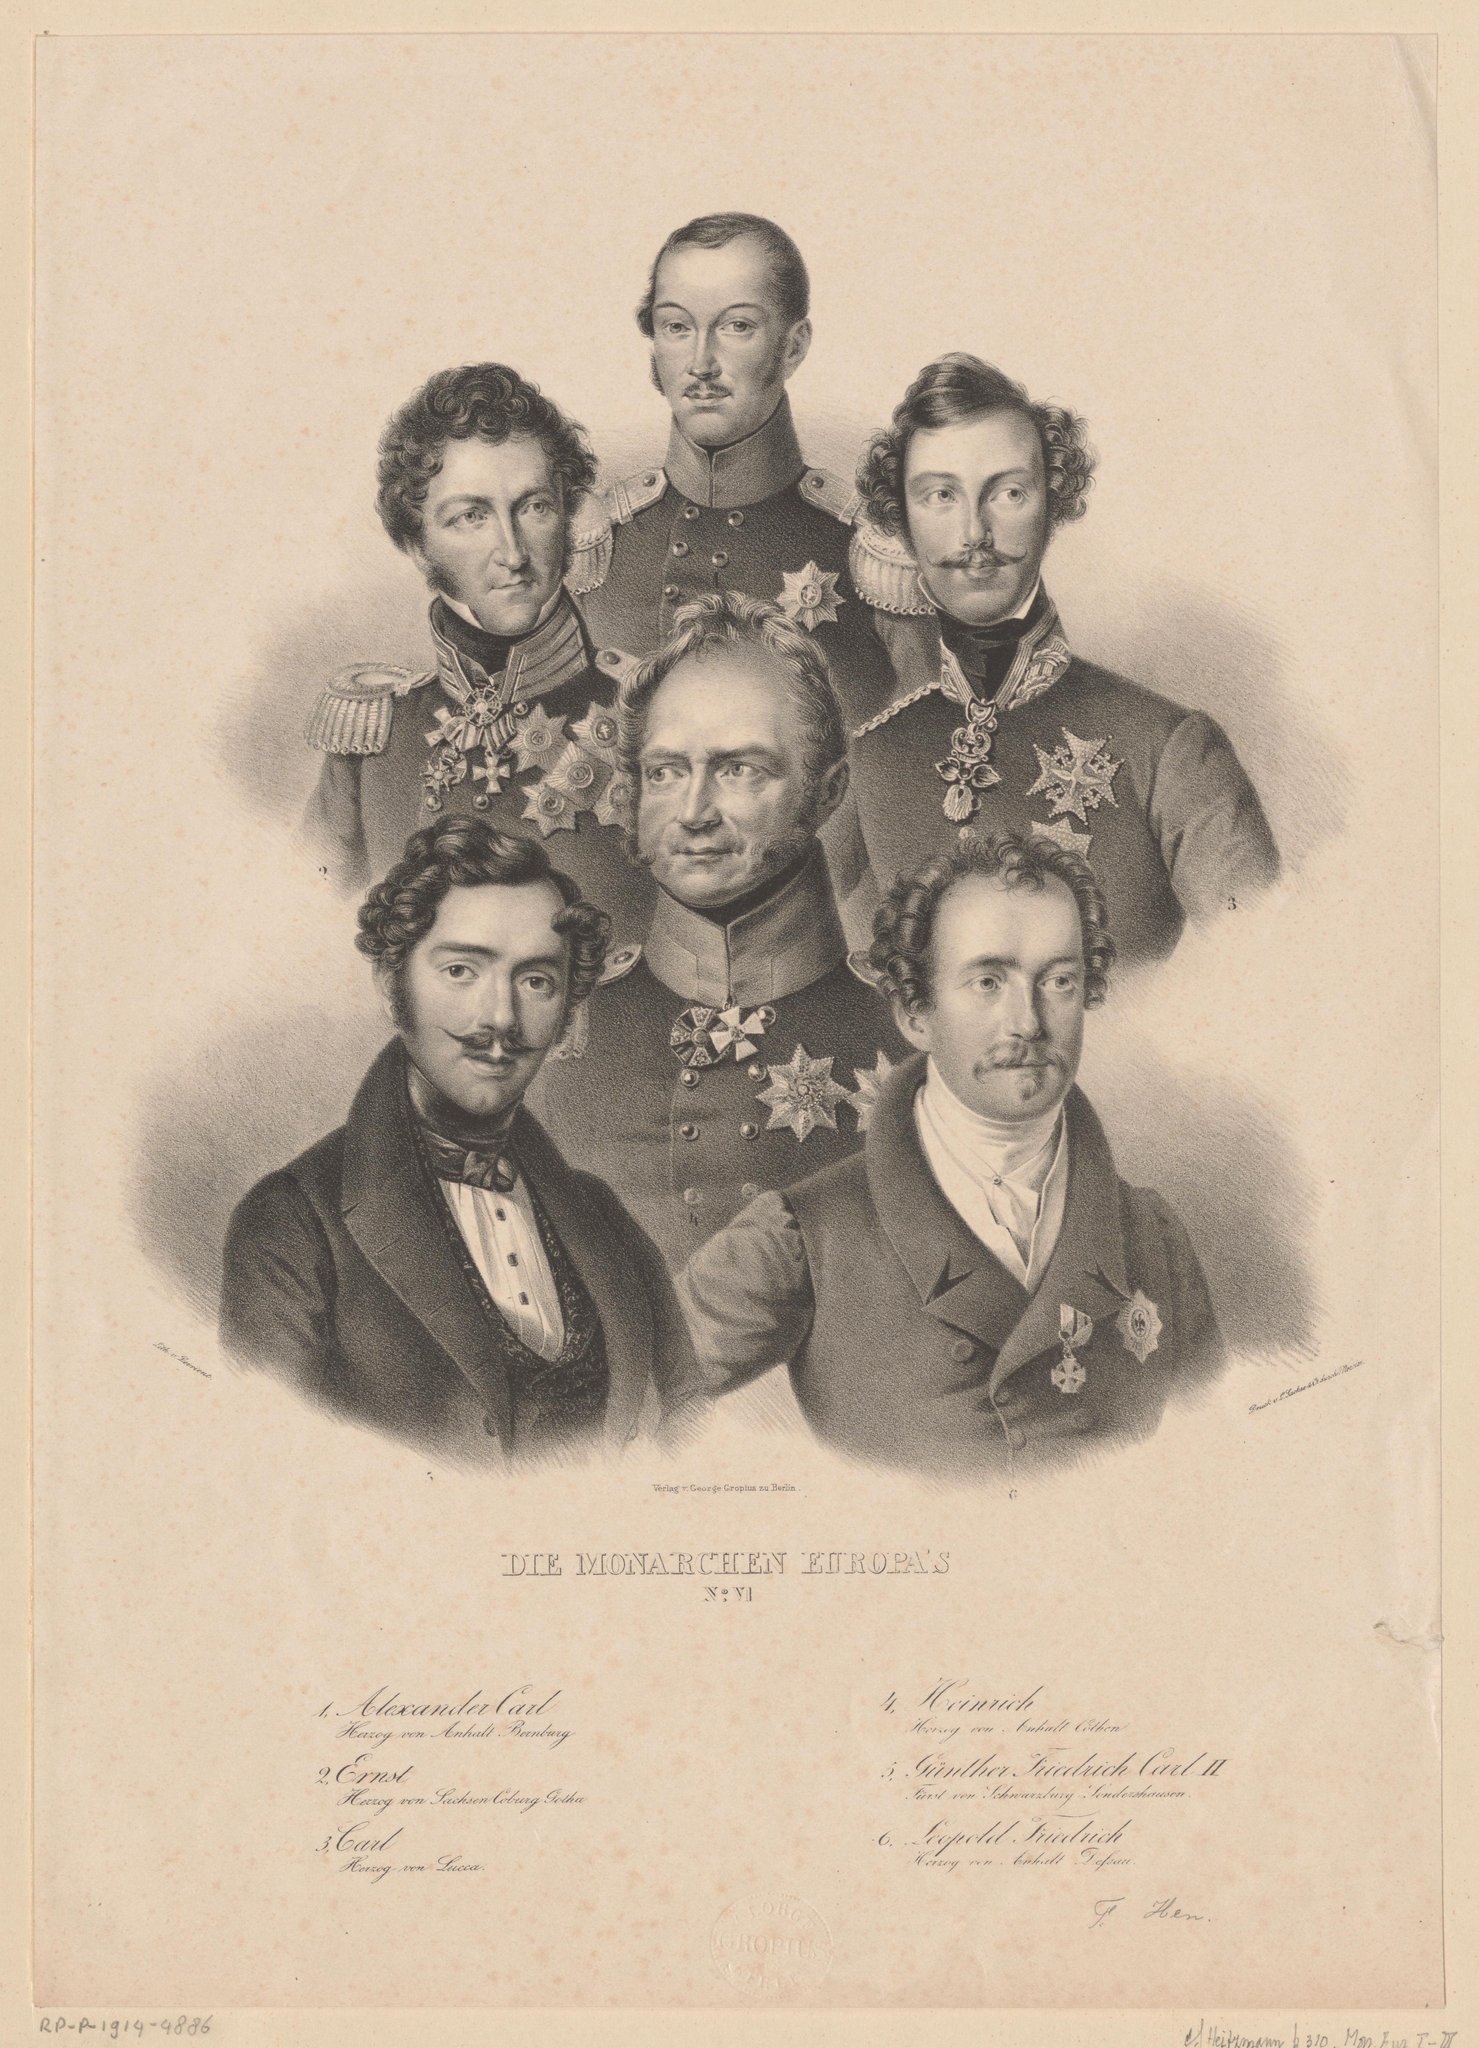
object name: print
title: Portretten van zes Europese monarchen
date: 1832-1842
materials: paper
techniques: lithograph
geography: berlin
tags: knighthood order, historical persons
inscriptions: check stamp: Lugt 4221, collector's mark: Lugt 2228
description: Portretten van Alexander Karl von Anhalt-Bernburg, Ernst I van Saksen-Coburg en Gotha, Karel Lodewijk Ferdinand van Bourbon-Parma, Hendrik van Anhalt-Köthen, Günther Frederik Karel II van Schwarzburg-Sondershausen en Leopold IV Frederik van Anhalt. In het midden genummerd: N; VI.